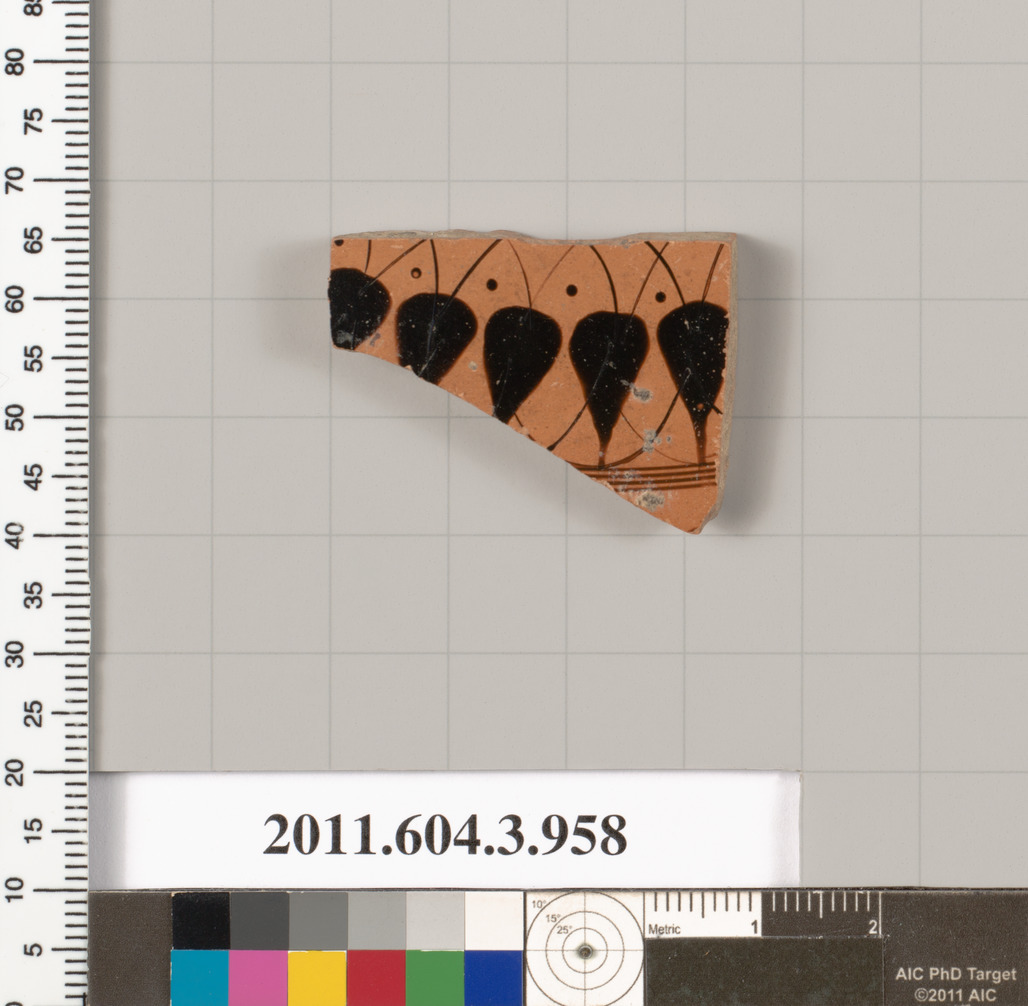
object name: lekanis lid fragment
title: Terracotta fragment of a lekanis lid (covered dish)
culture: greek, attic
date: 600-501 BCE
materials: terracotta